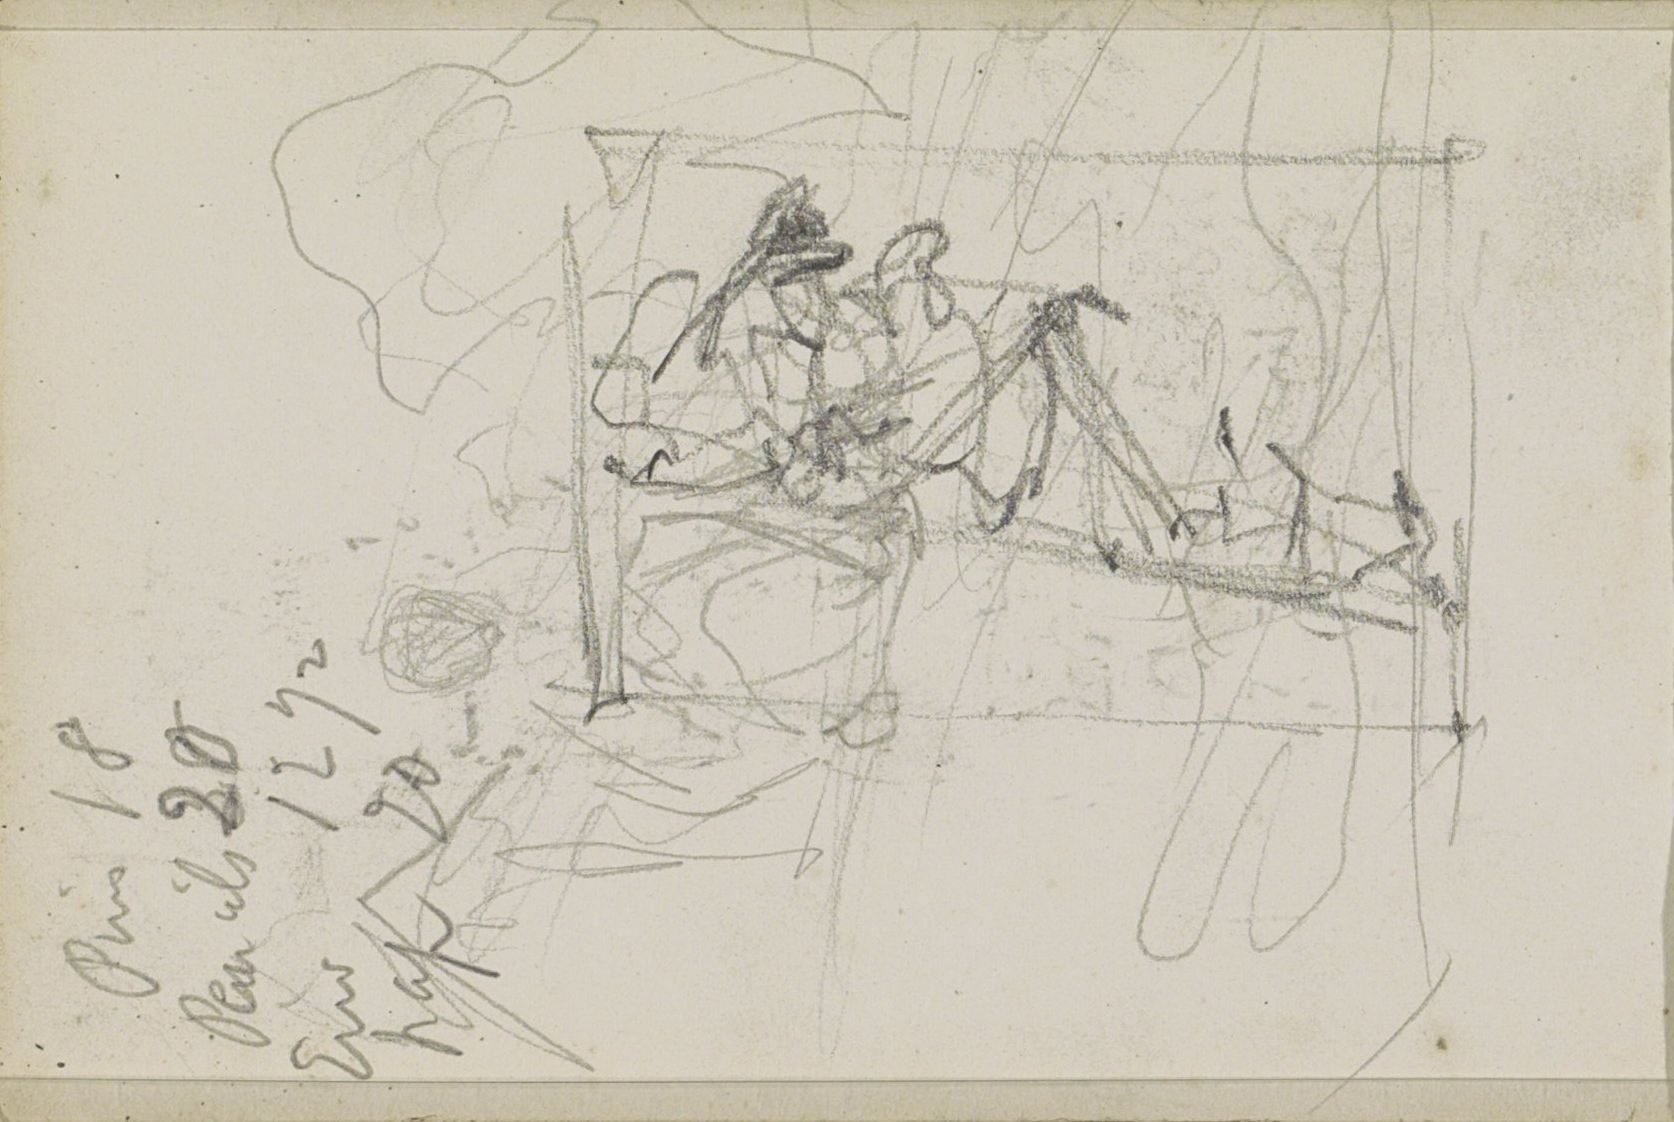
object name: sketchbook leaf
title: Studie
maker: george clausen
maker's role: draughtsman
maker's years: 1852-1912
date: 1875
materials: paper, pencil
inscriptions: annotation: ‘pins 18/ pe[...]ils 20/ E[...] 12 72/ hap 20’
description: Blad 1 verso uit een schetsboek met 38 bladen.